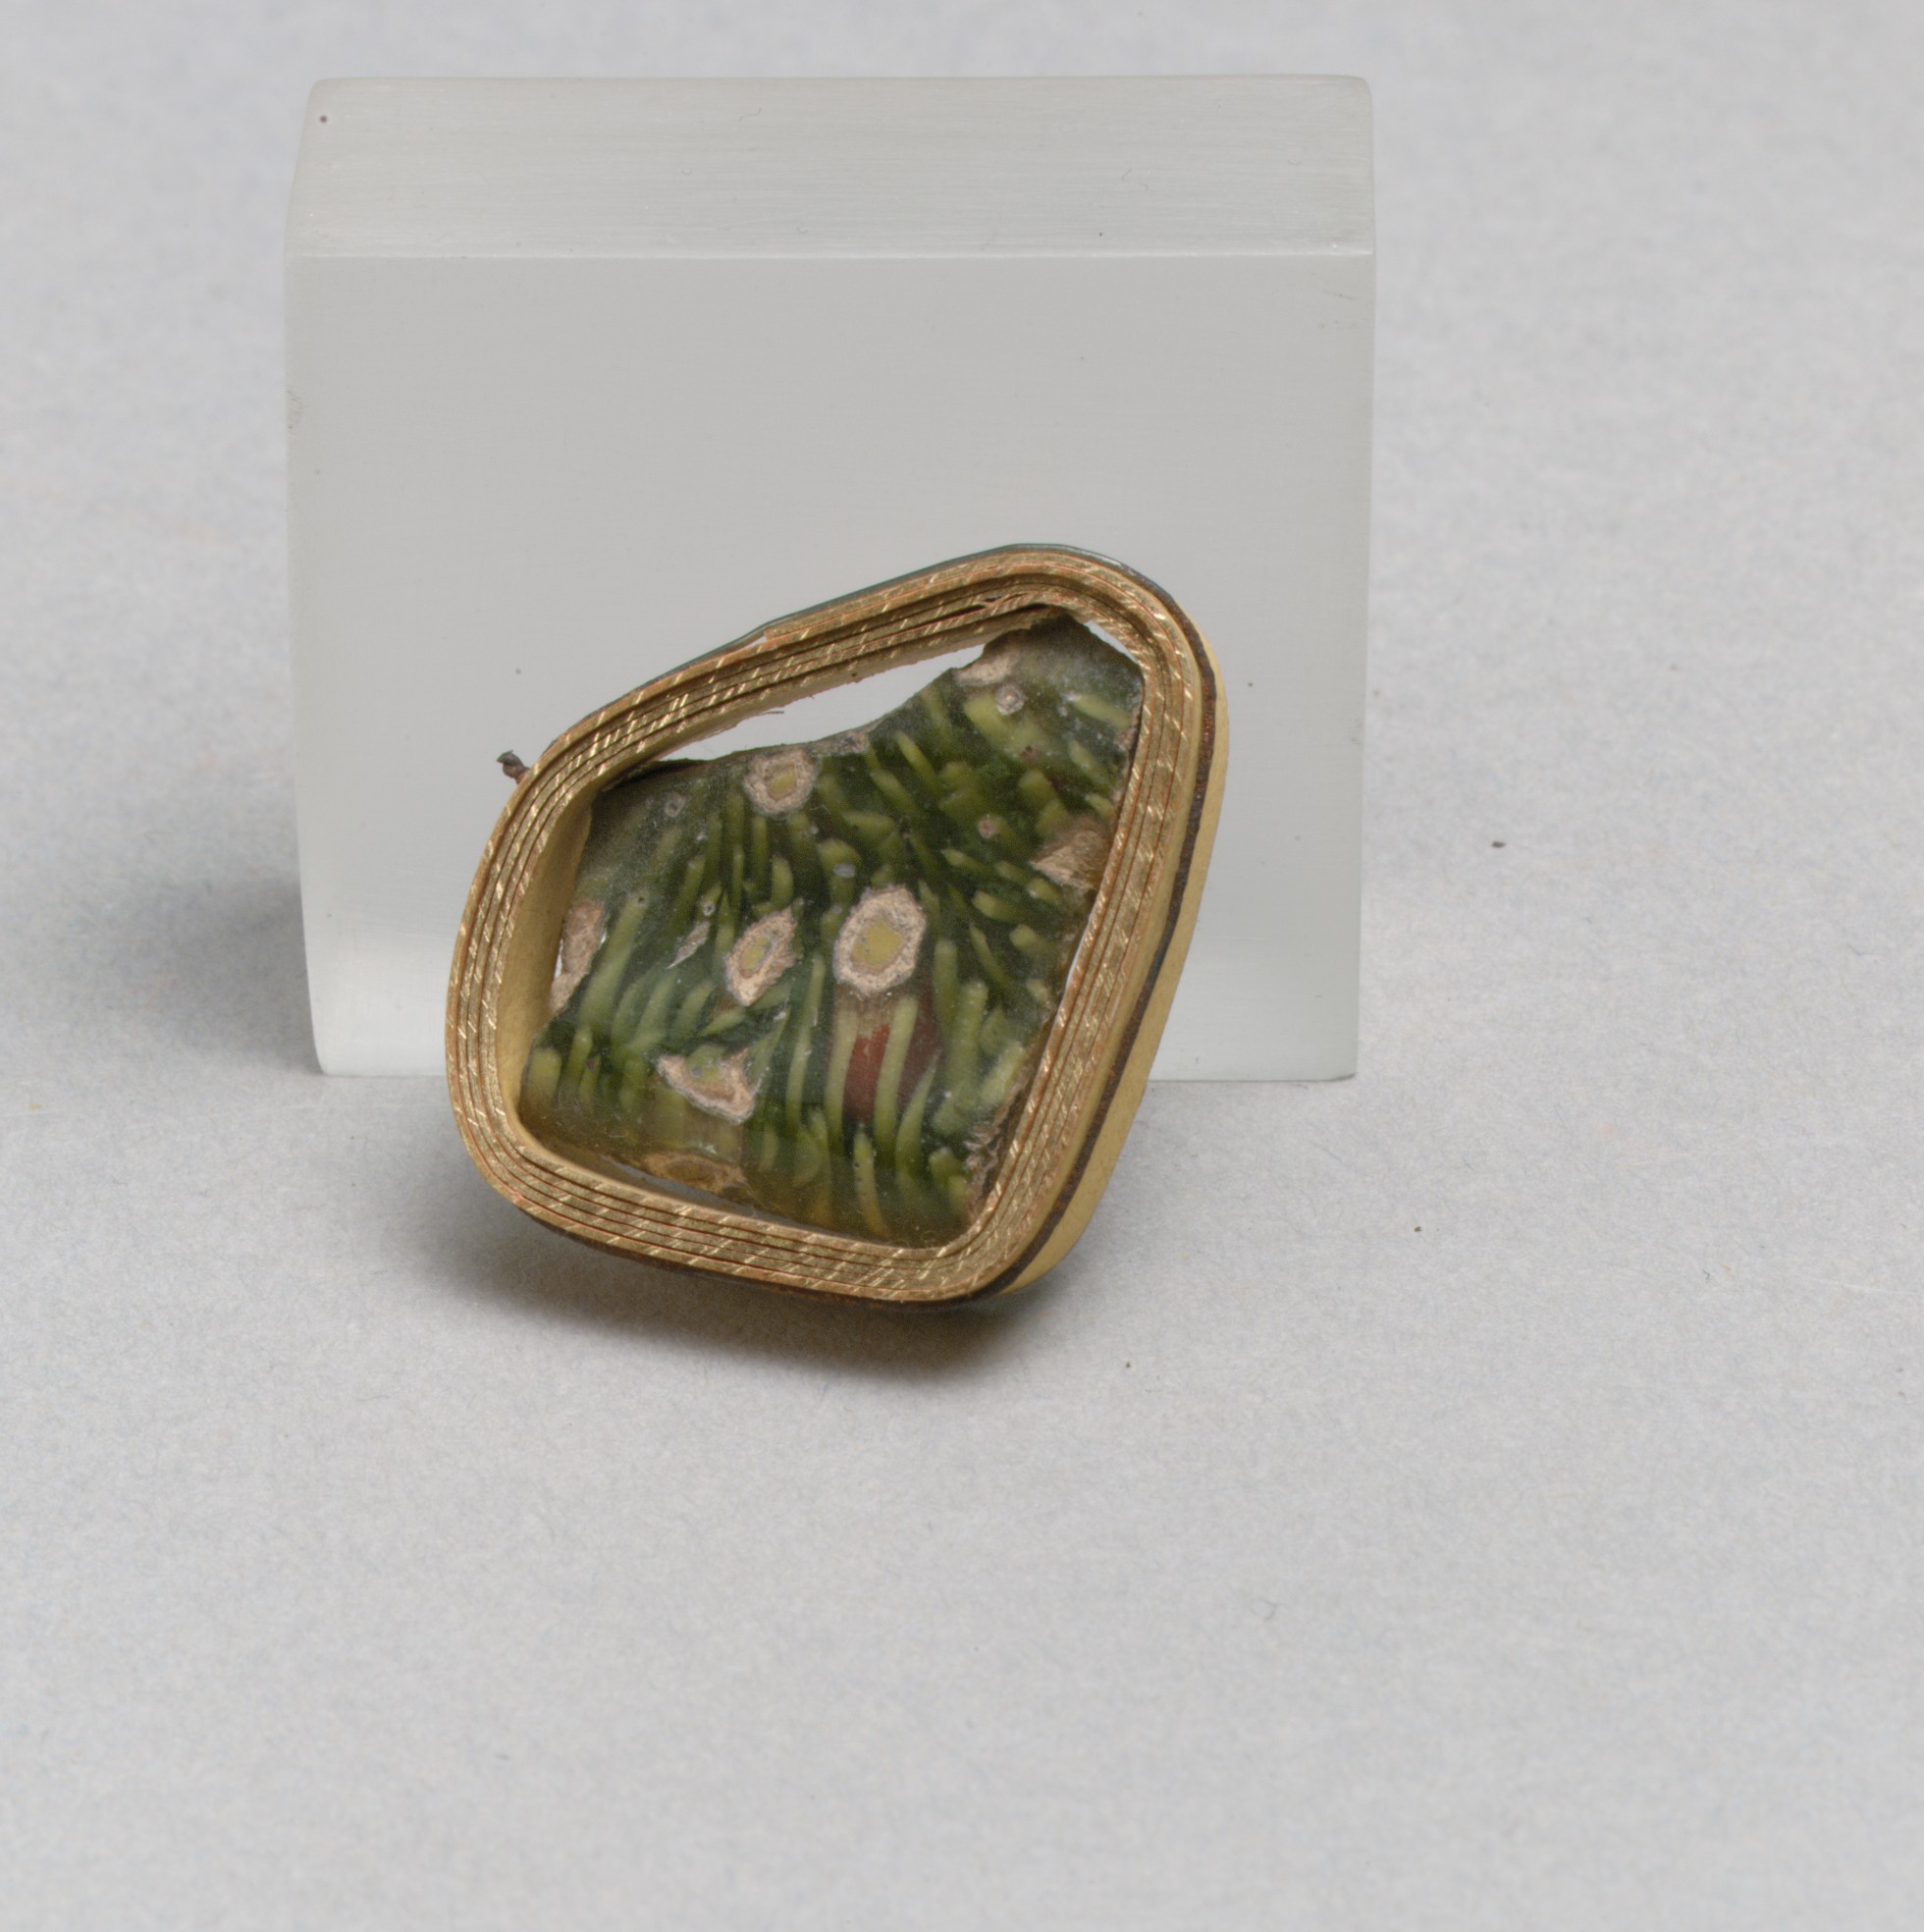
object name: fragment, mosaic bowl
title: Glass mosaic carinated bowl fragment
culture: roman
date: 34 BCE-33 CE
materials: glass